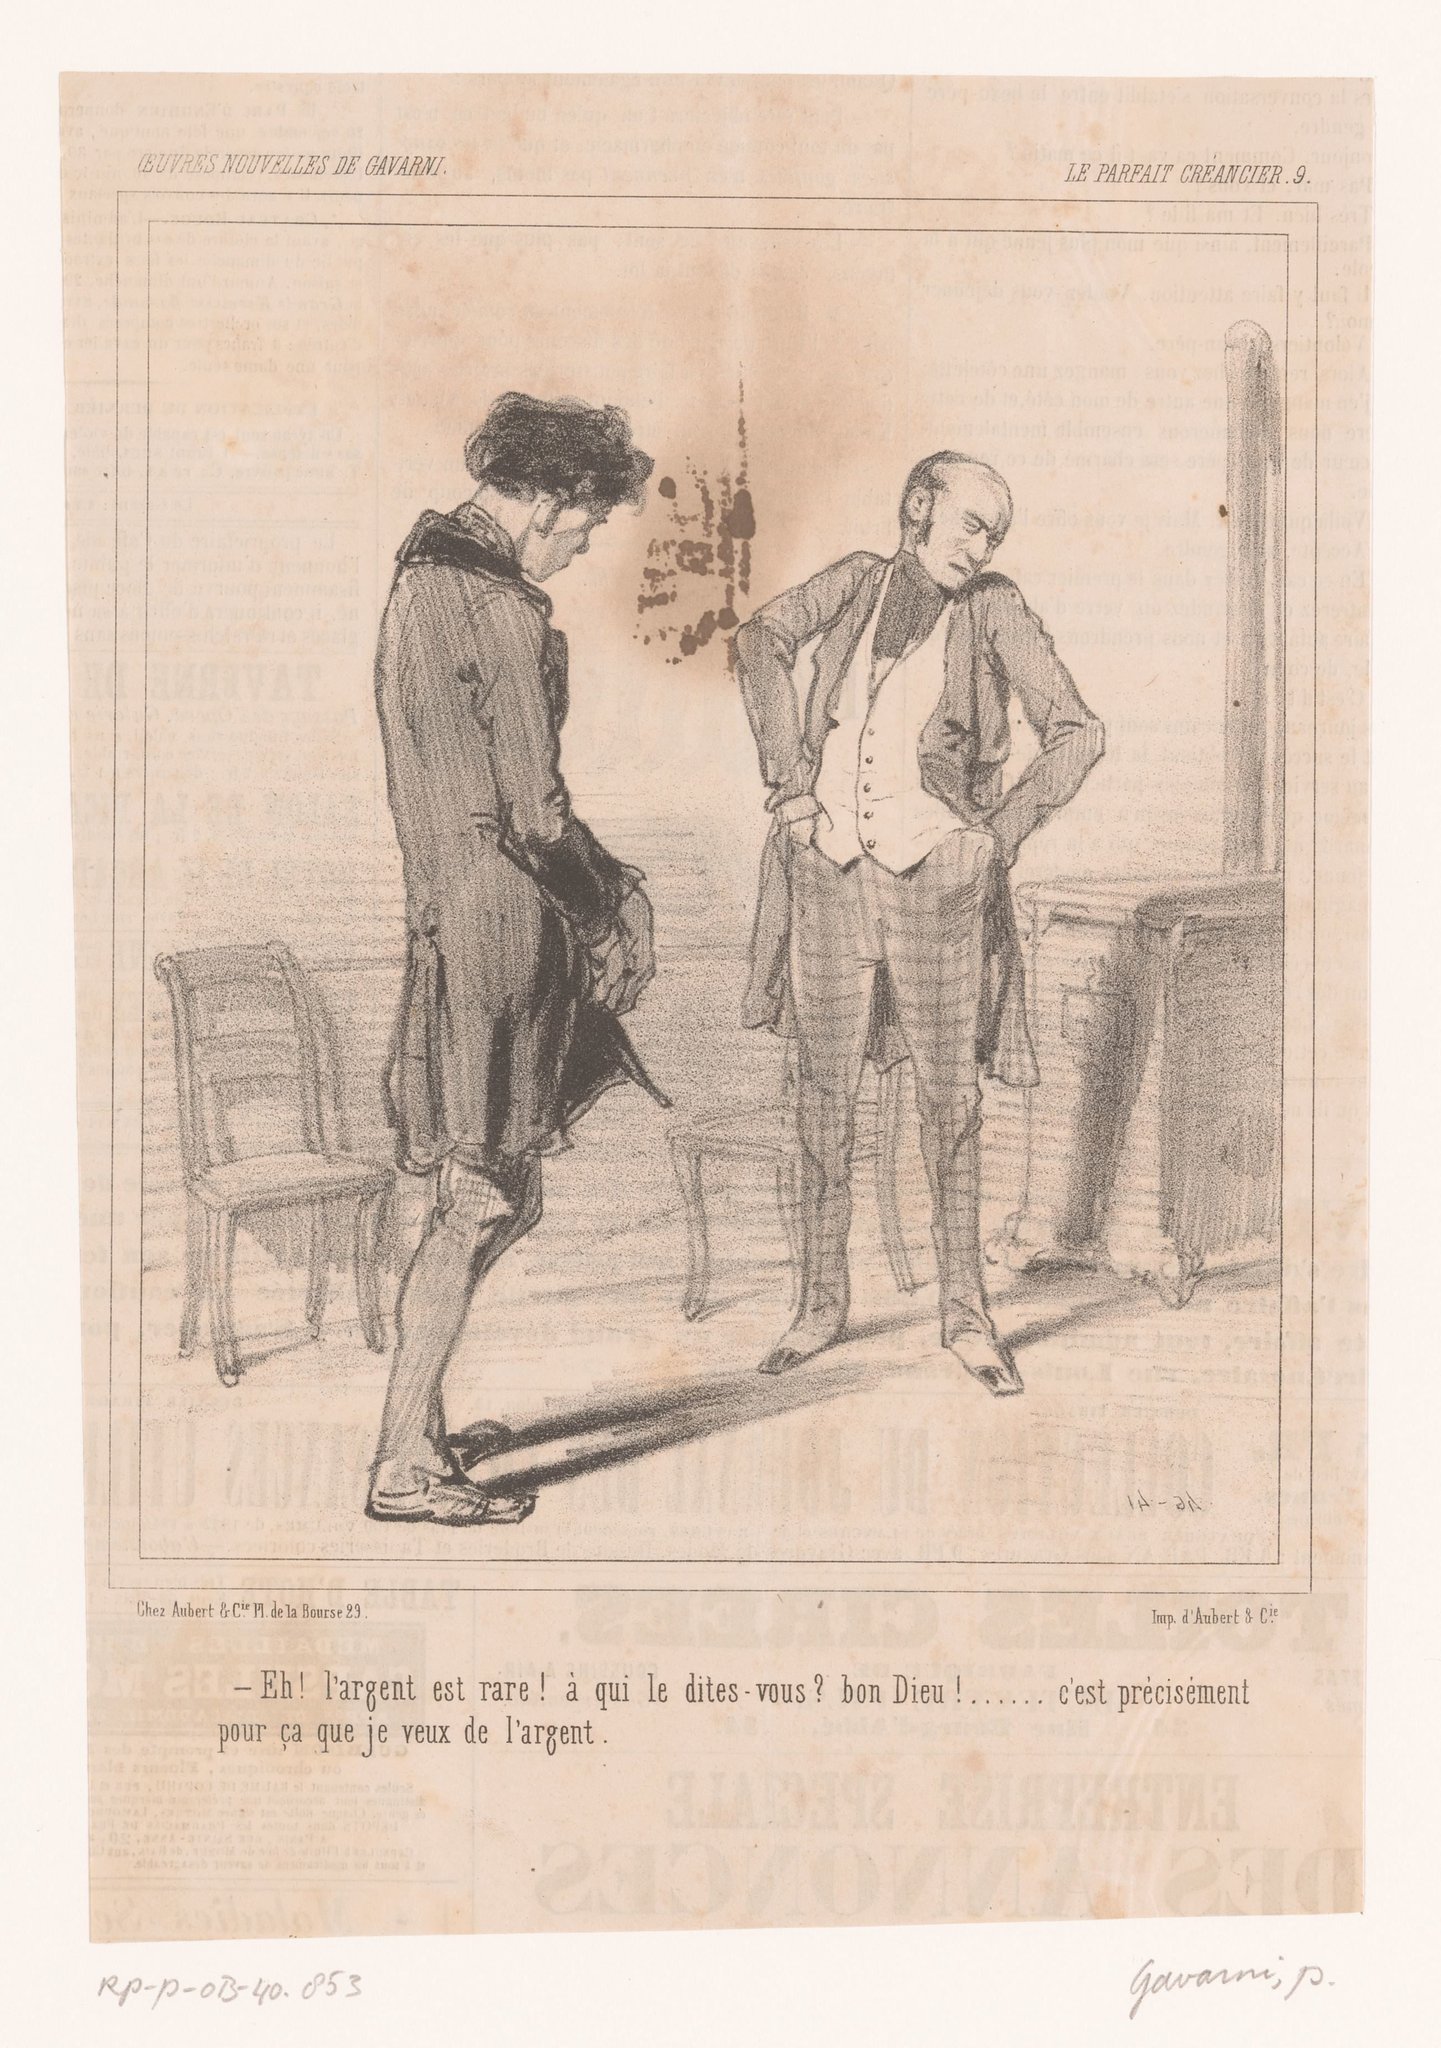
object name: print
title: Schuldeisers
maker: paul gavarni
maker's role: draughtsman, print maker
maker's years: 1804-1866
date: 1846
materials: paper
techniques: lithograph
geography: paris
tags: debit, debt, money-lender, usurer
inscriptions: collector's mark: Lugt 2228a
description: Prent gebruikt voor: Le Charivari, 20 september 1846.